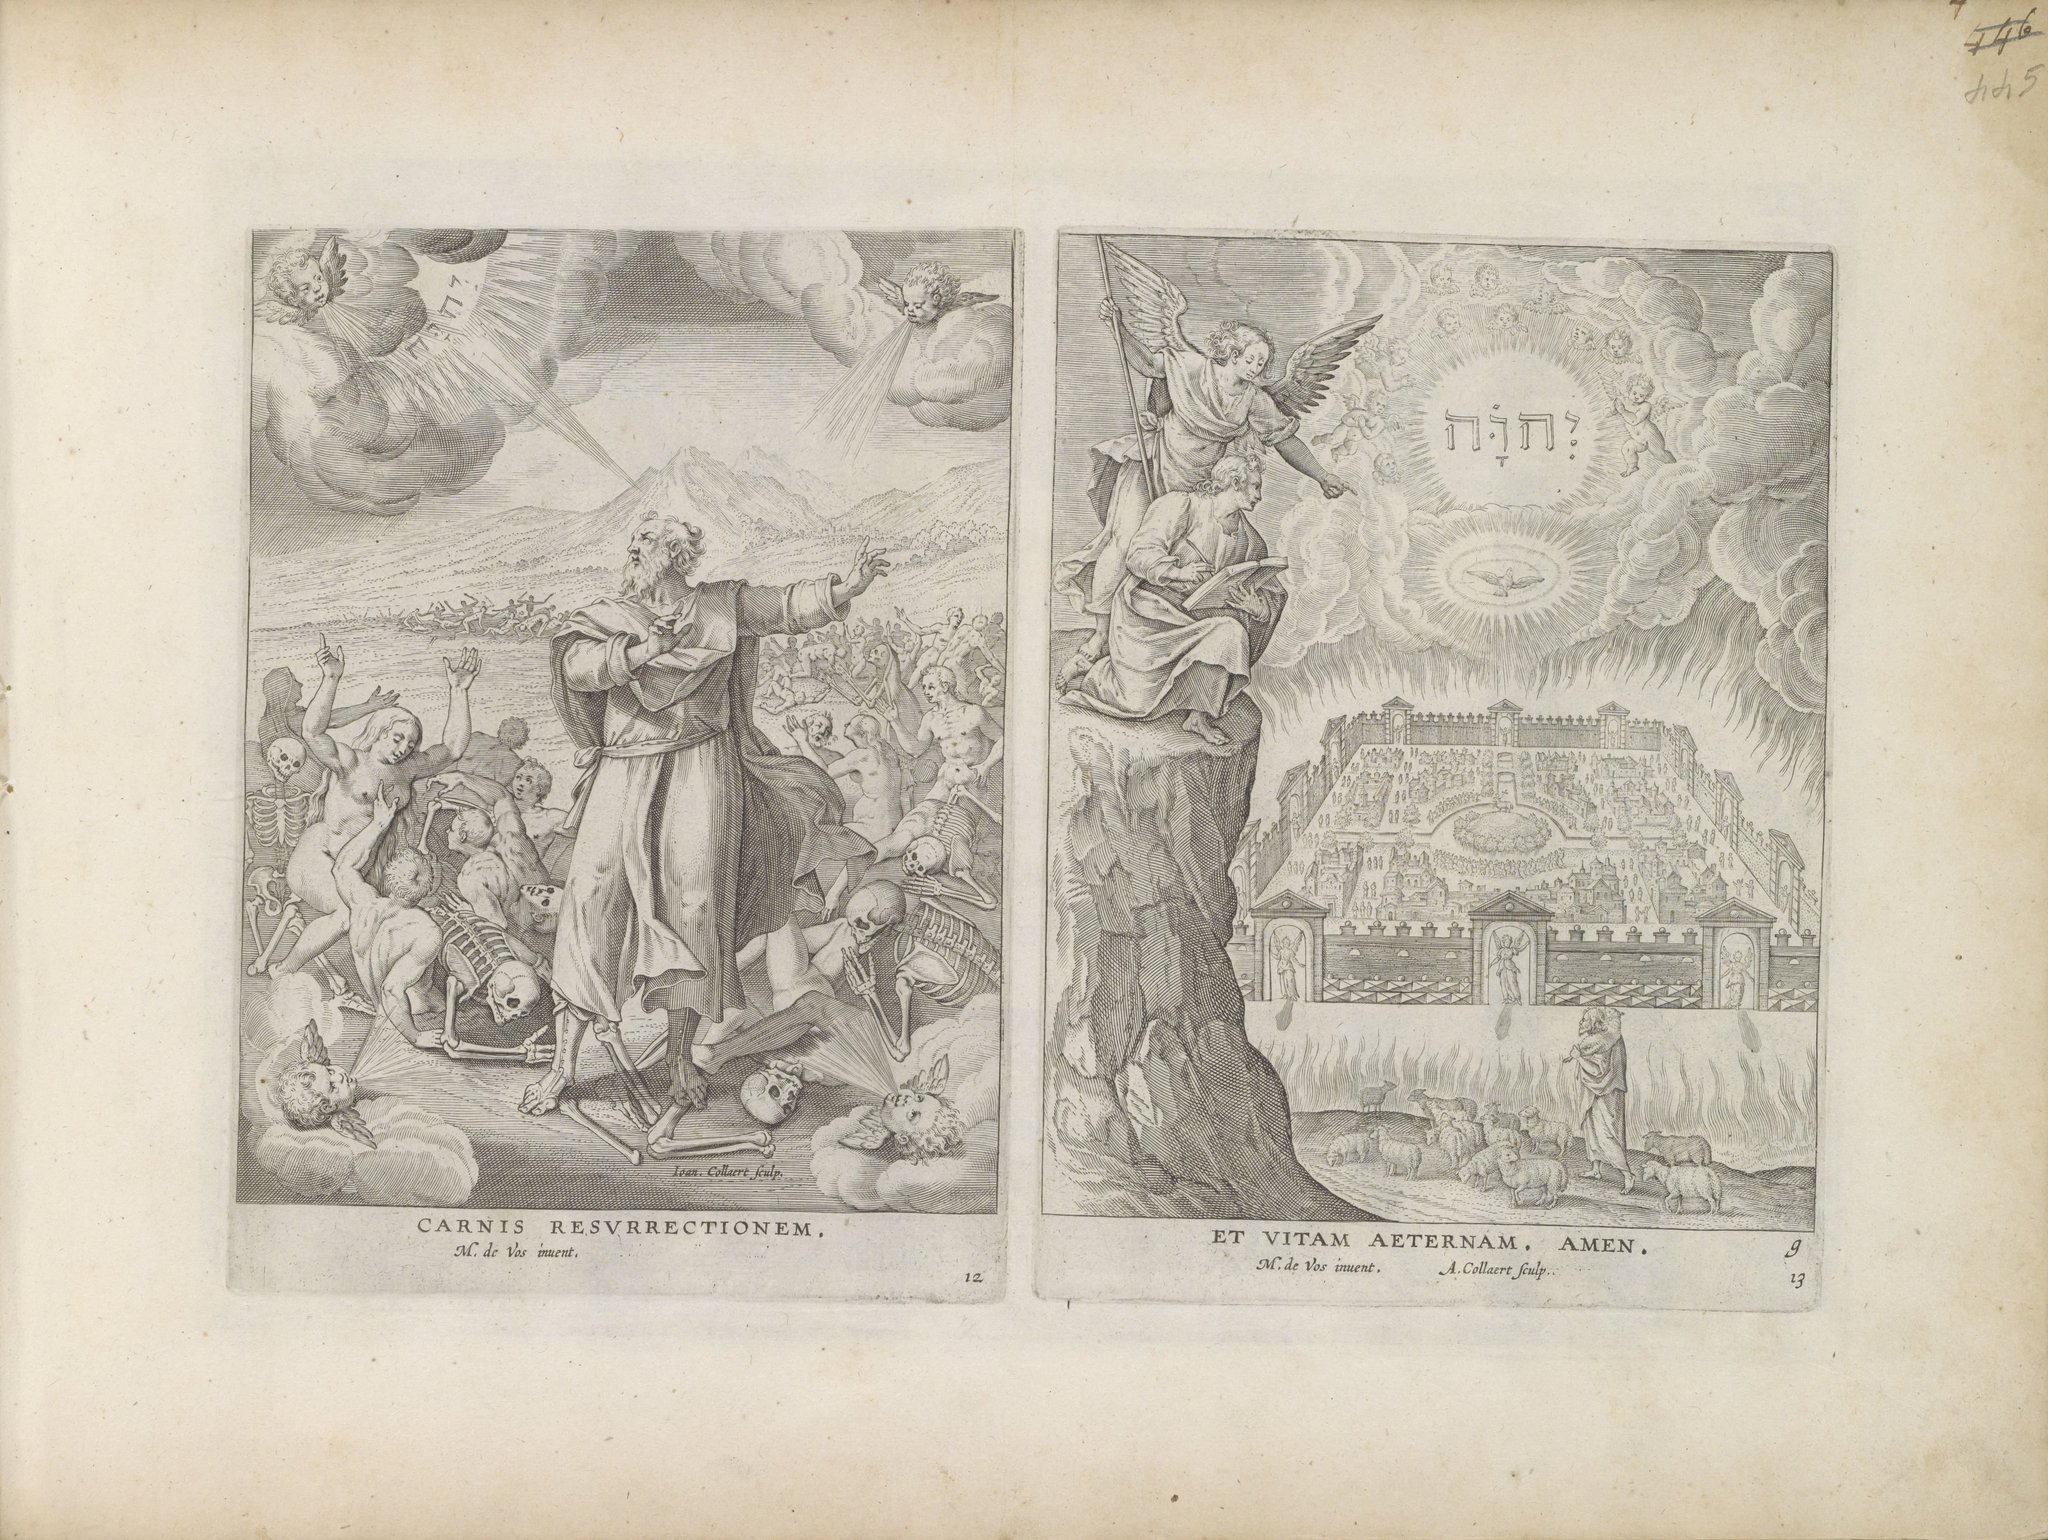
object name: print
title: Theatrum Biblicum Hoc Est Historiae Sacrae Veteris et Novi Testamenti Tabulis Aeneis Expressae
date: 1570-1618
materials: paper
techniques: engraving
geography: amsterdam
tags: the new jerusalem, an angel shows john the new (heavenly) jerusalem coming down from heaven; sometimes christ is shown leading his lambs to the city, 'vitam aeternam' ~ articles of faith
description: Illustratie van het twaalfde geloofsartikel (het eeuwig leven) van de apostolische geloofsbelijdenis. Een engel heeft Johannes de Evangelist naar een bergtop gedragen en toont hem het nieuwe Jeruzalem. Johannes schrijft alles op in het boek Openbaringen. Jeruzalem heeft twaalf poorten, die bewaakt worden door twaalf engelen. De Goede Herder wandelt samen met zijn lammeren richting de poorten. God, in de gedaante van het tetragram, en de Heilige Geest verschijnen in de wolken, samen met enkele engelen. Deze prent maakt deel uit van een album.